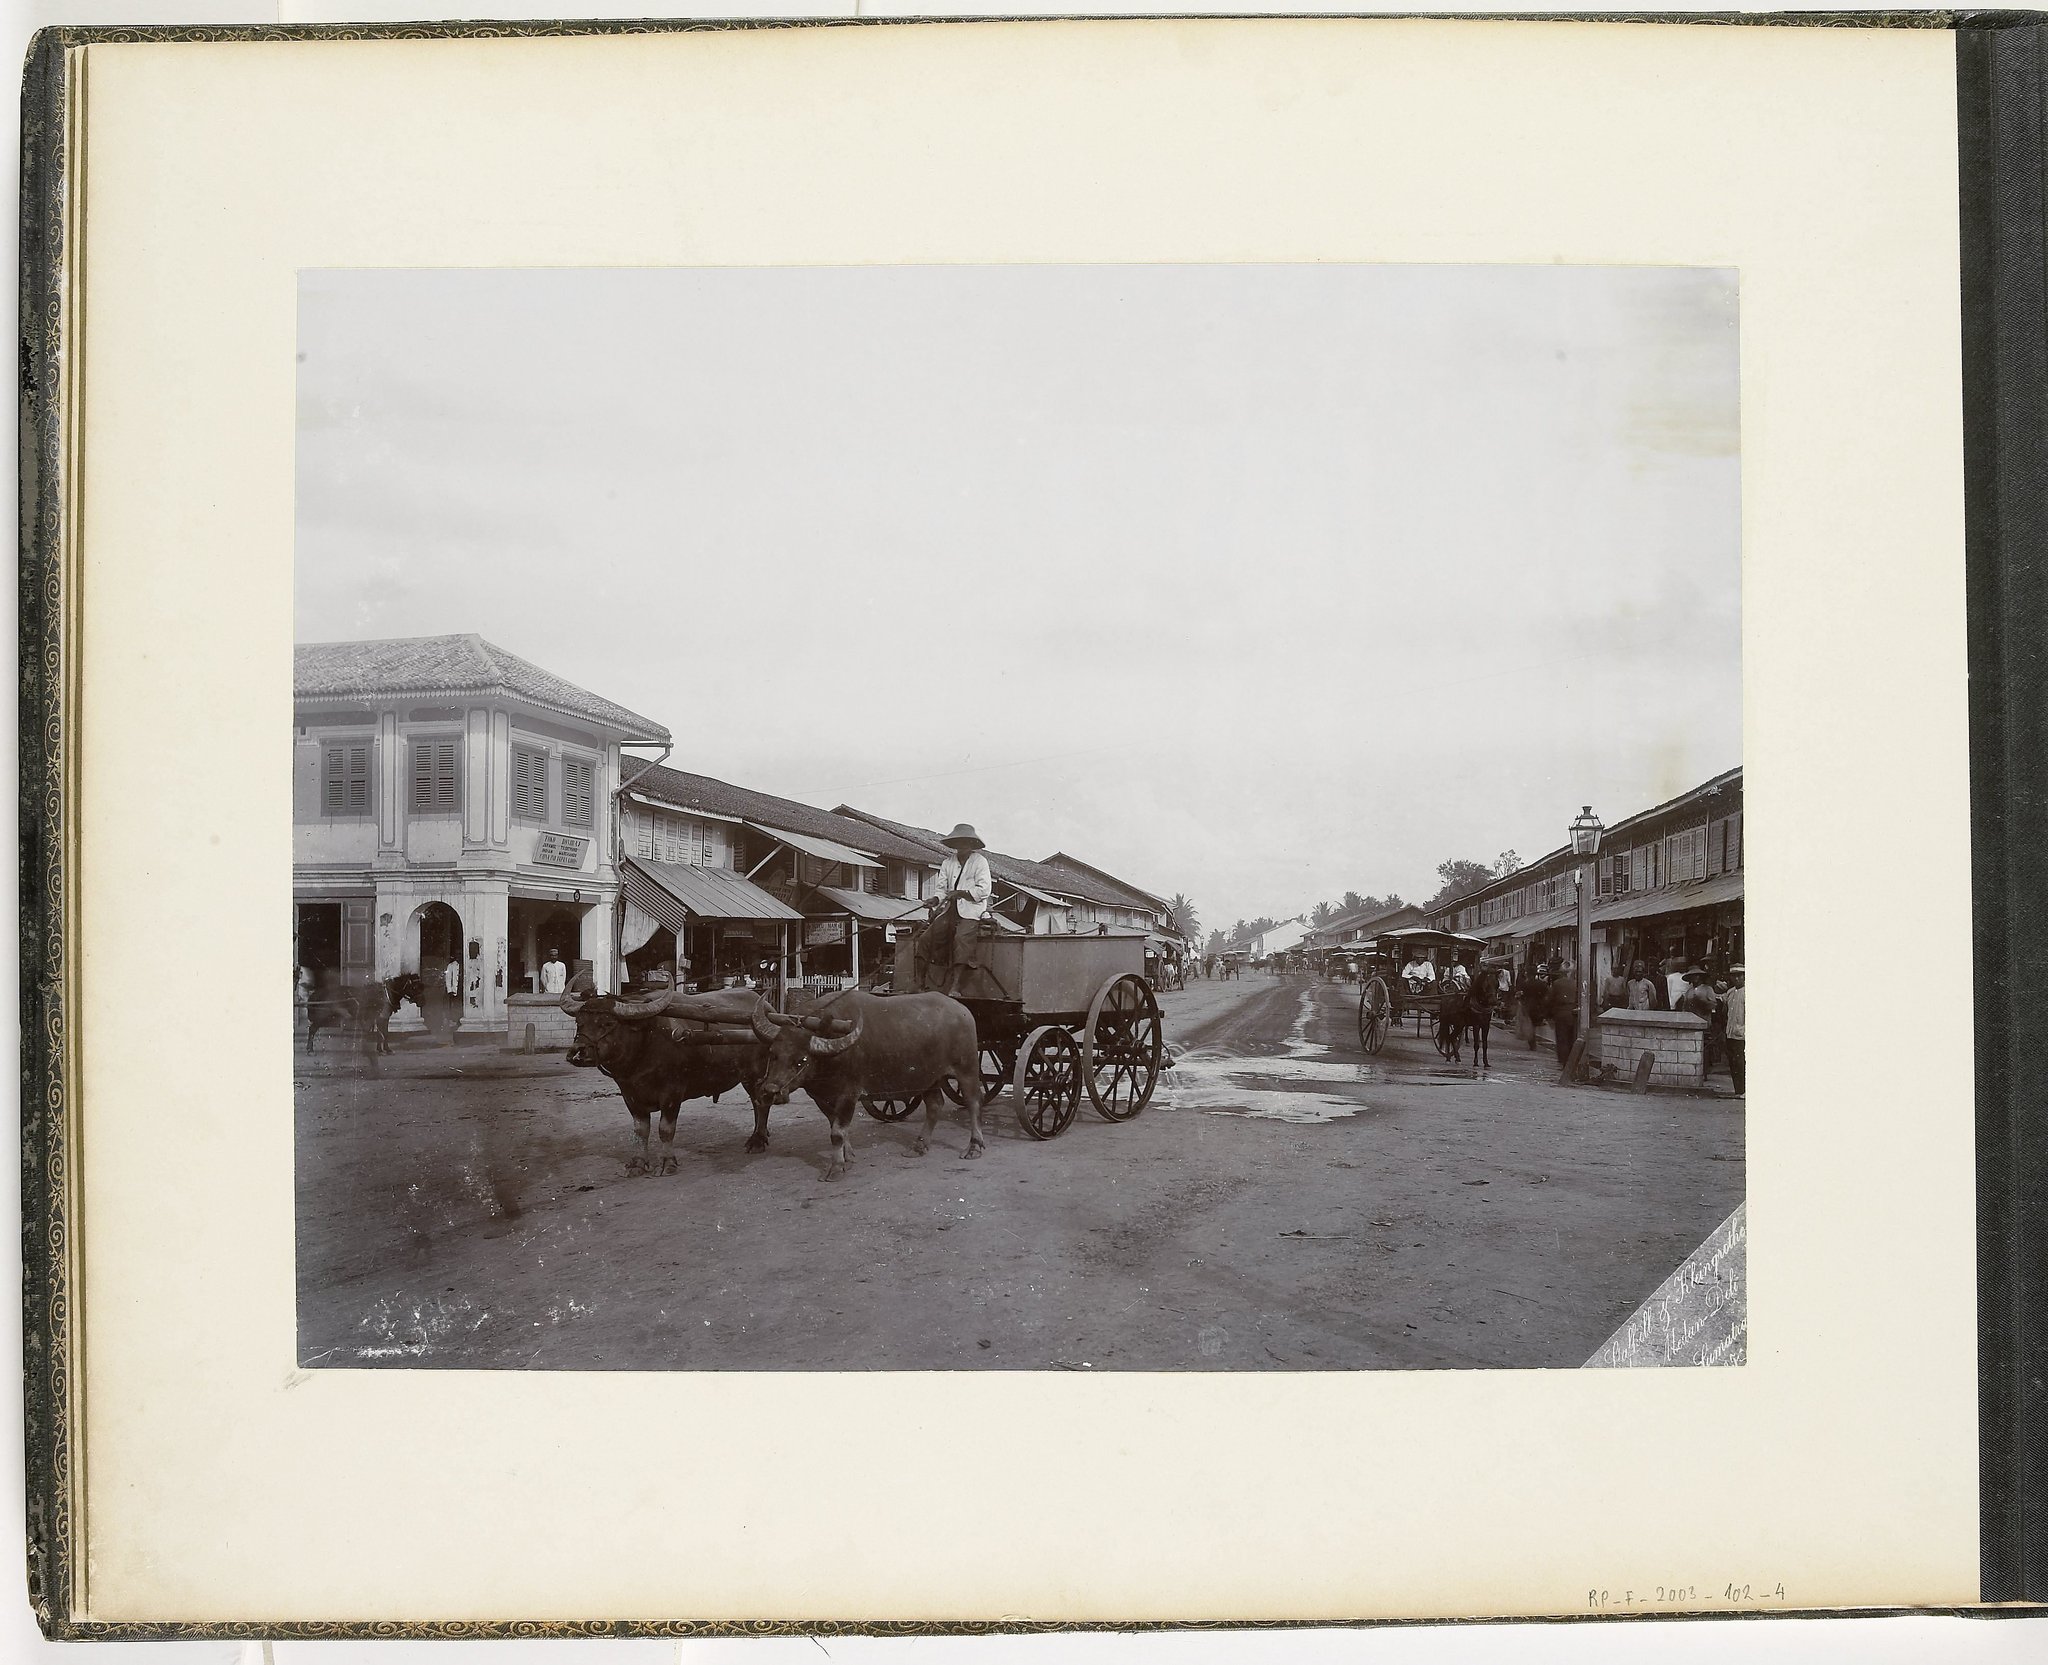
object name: photograph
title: Gezicht op Kesawanstraat in Medan, Sumatra (Kesawanstrasse von Norden gesehen)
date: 1890-1900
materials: photographic support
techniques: collodion silver print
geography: medan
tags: medan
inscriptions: number: ‘Sumatra 25’, signature: ‘Stafhell & Kleingrothe Medan-Deli’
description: Gezicht vanuit het noorden in de Kesawanstraat in Medan, Sumatra. In het midden van de weg een wagen getrokken door twee karbouwen waarmee de onverharde weg met water besproeid wordt.